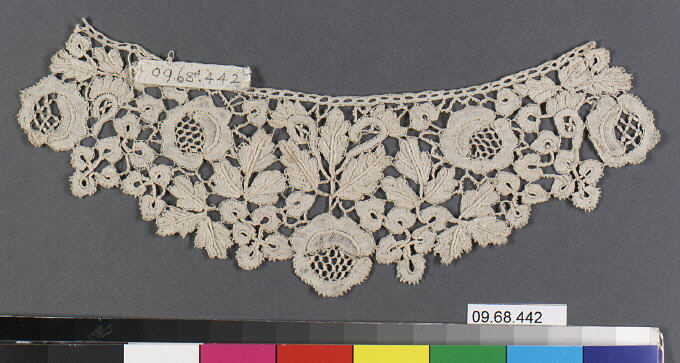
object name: cuff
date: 1801-1900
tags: flowers